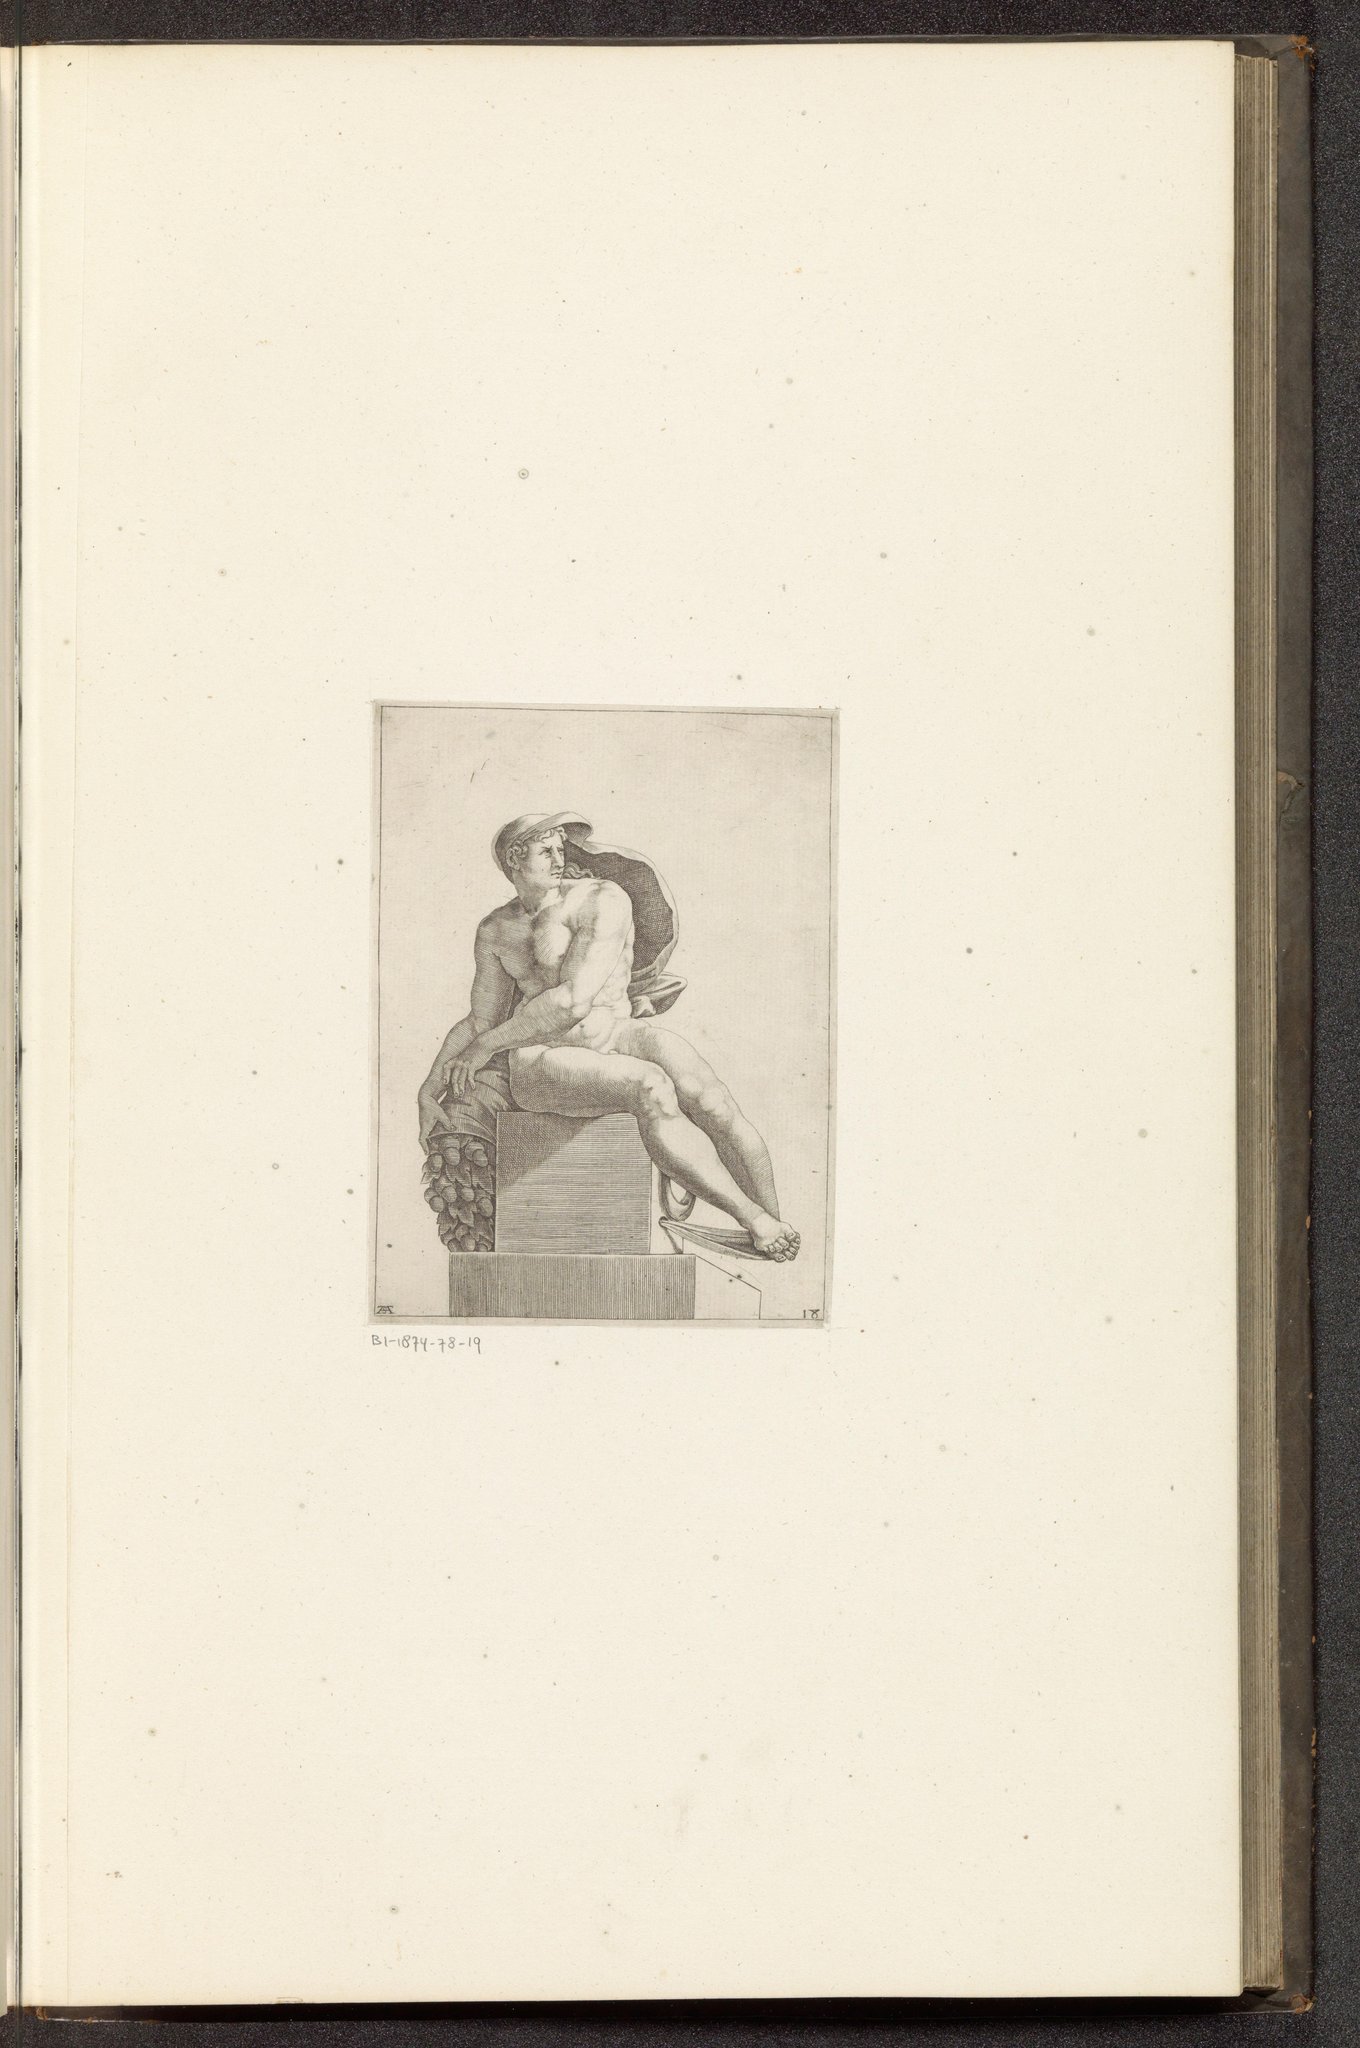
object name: print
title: Zittend naakt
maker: adamo scultori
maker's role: painter, print maker, sculptor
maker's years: 1530-1585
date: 1585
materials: paper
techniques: engraving, intaglio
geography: vatican city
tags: the (nude) human figure; 'corpo humano' (ripa), fruits: acorn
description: Zittende naakte man, naar rechts gedraaid, met een doek over zijn hoofd en een guirlande van eikels. Eén van de 'ignudi' (naakte mannen) van Michelangelo's plafondschildering. Genummerd rechtsonder: 18. De prent maakt deel uit van een album.